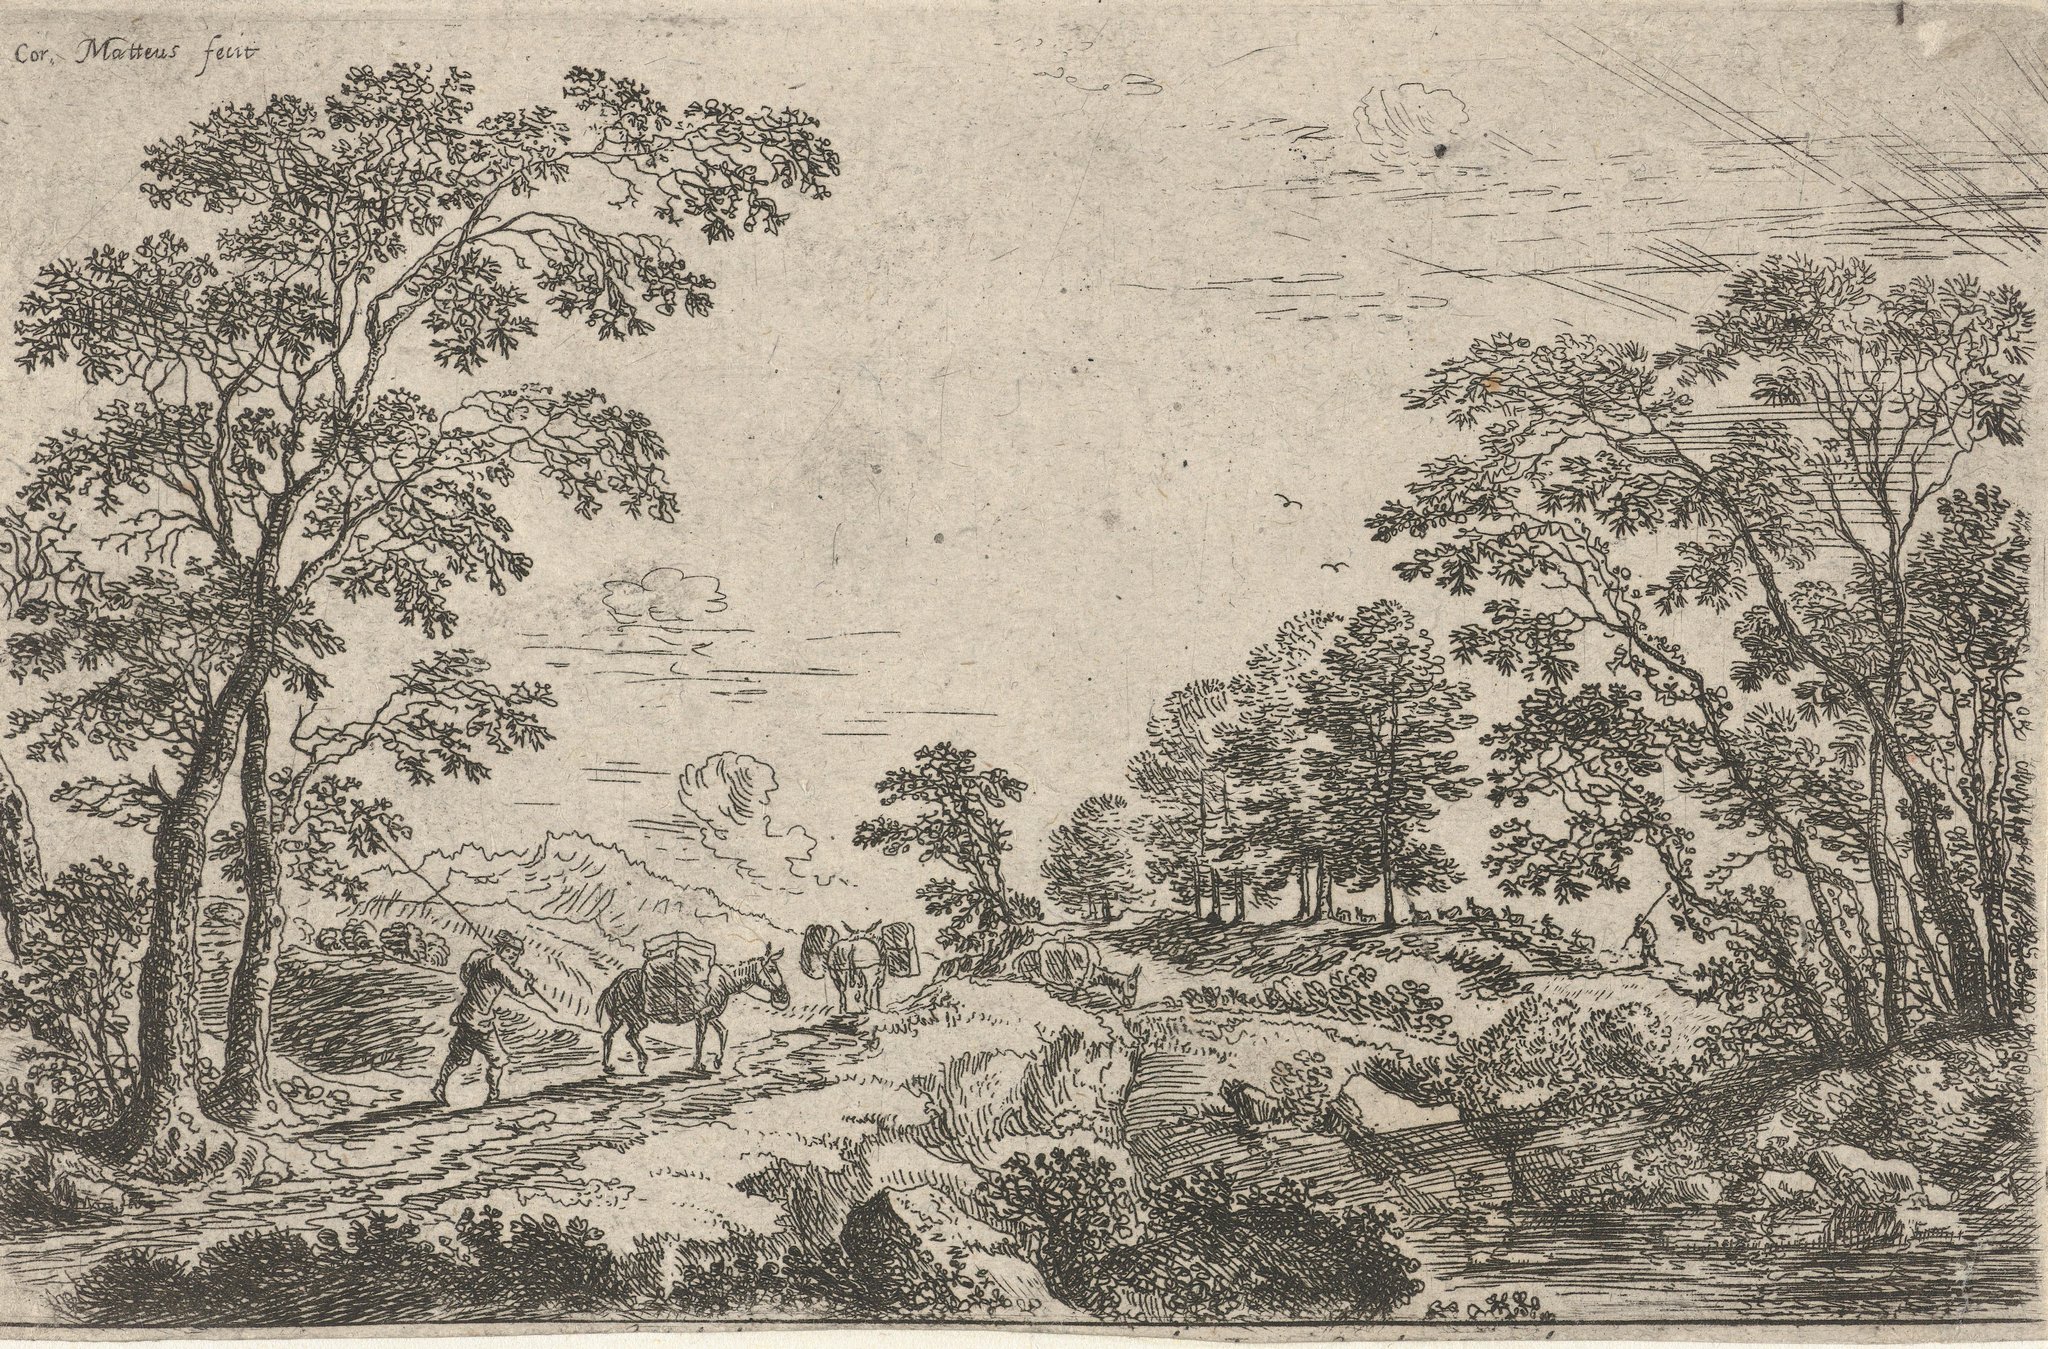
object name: print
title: Landschap met muilezeldrijver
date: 1637-1656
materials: paper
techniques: etching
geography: antwerp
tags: landscapes in the temperate zone, mule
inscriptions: collector's mark: Lugt 2228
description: Landschap met een muilezeldrijver en drie ezels.